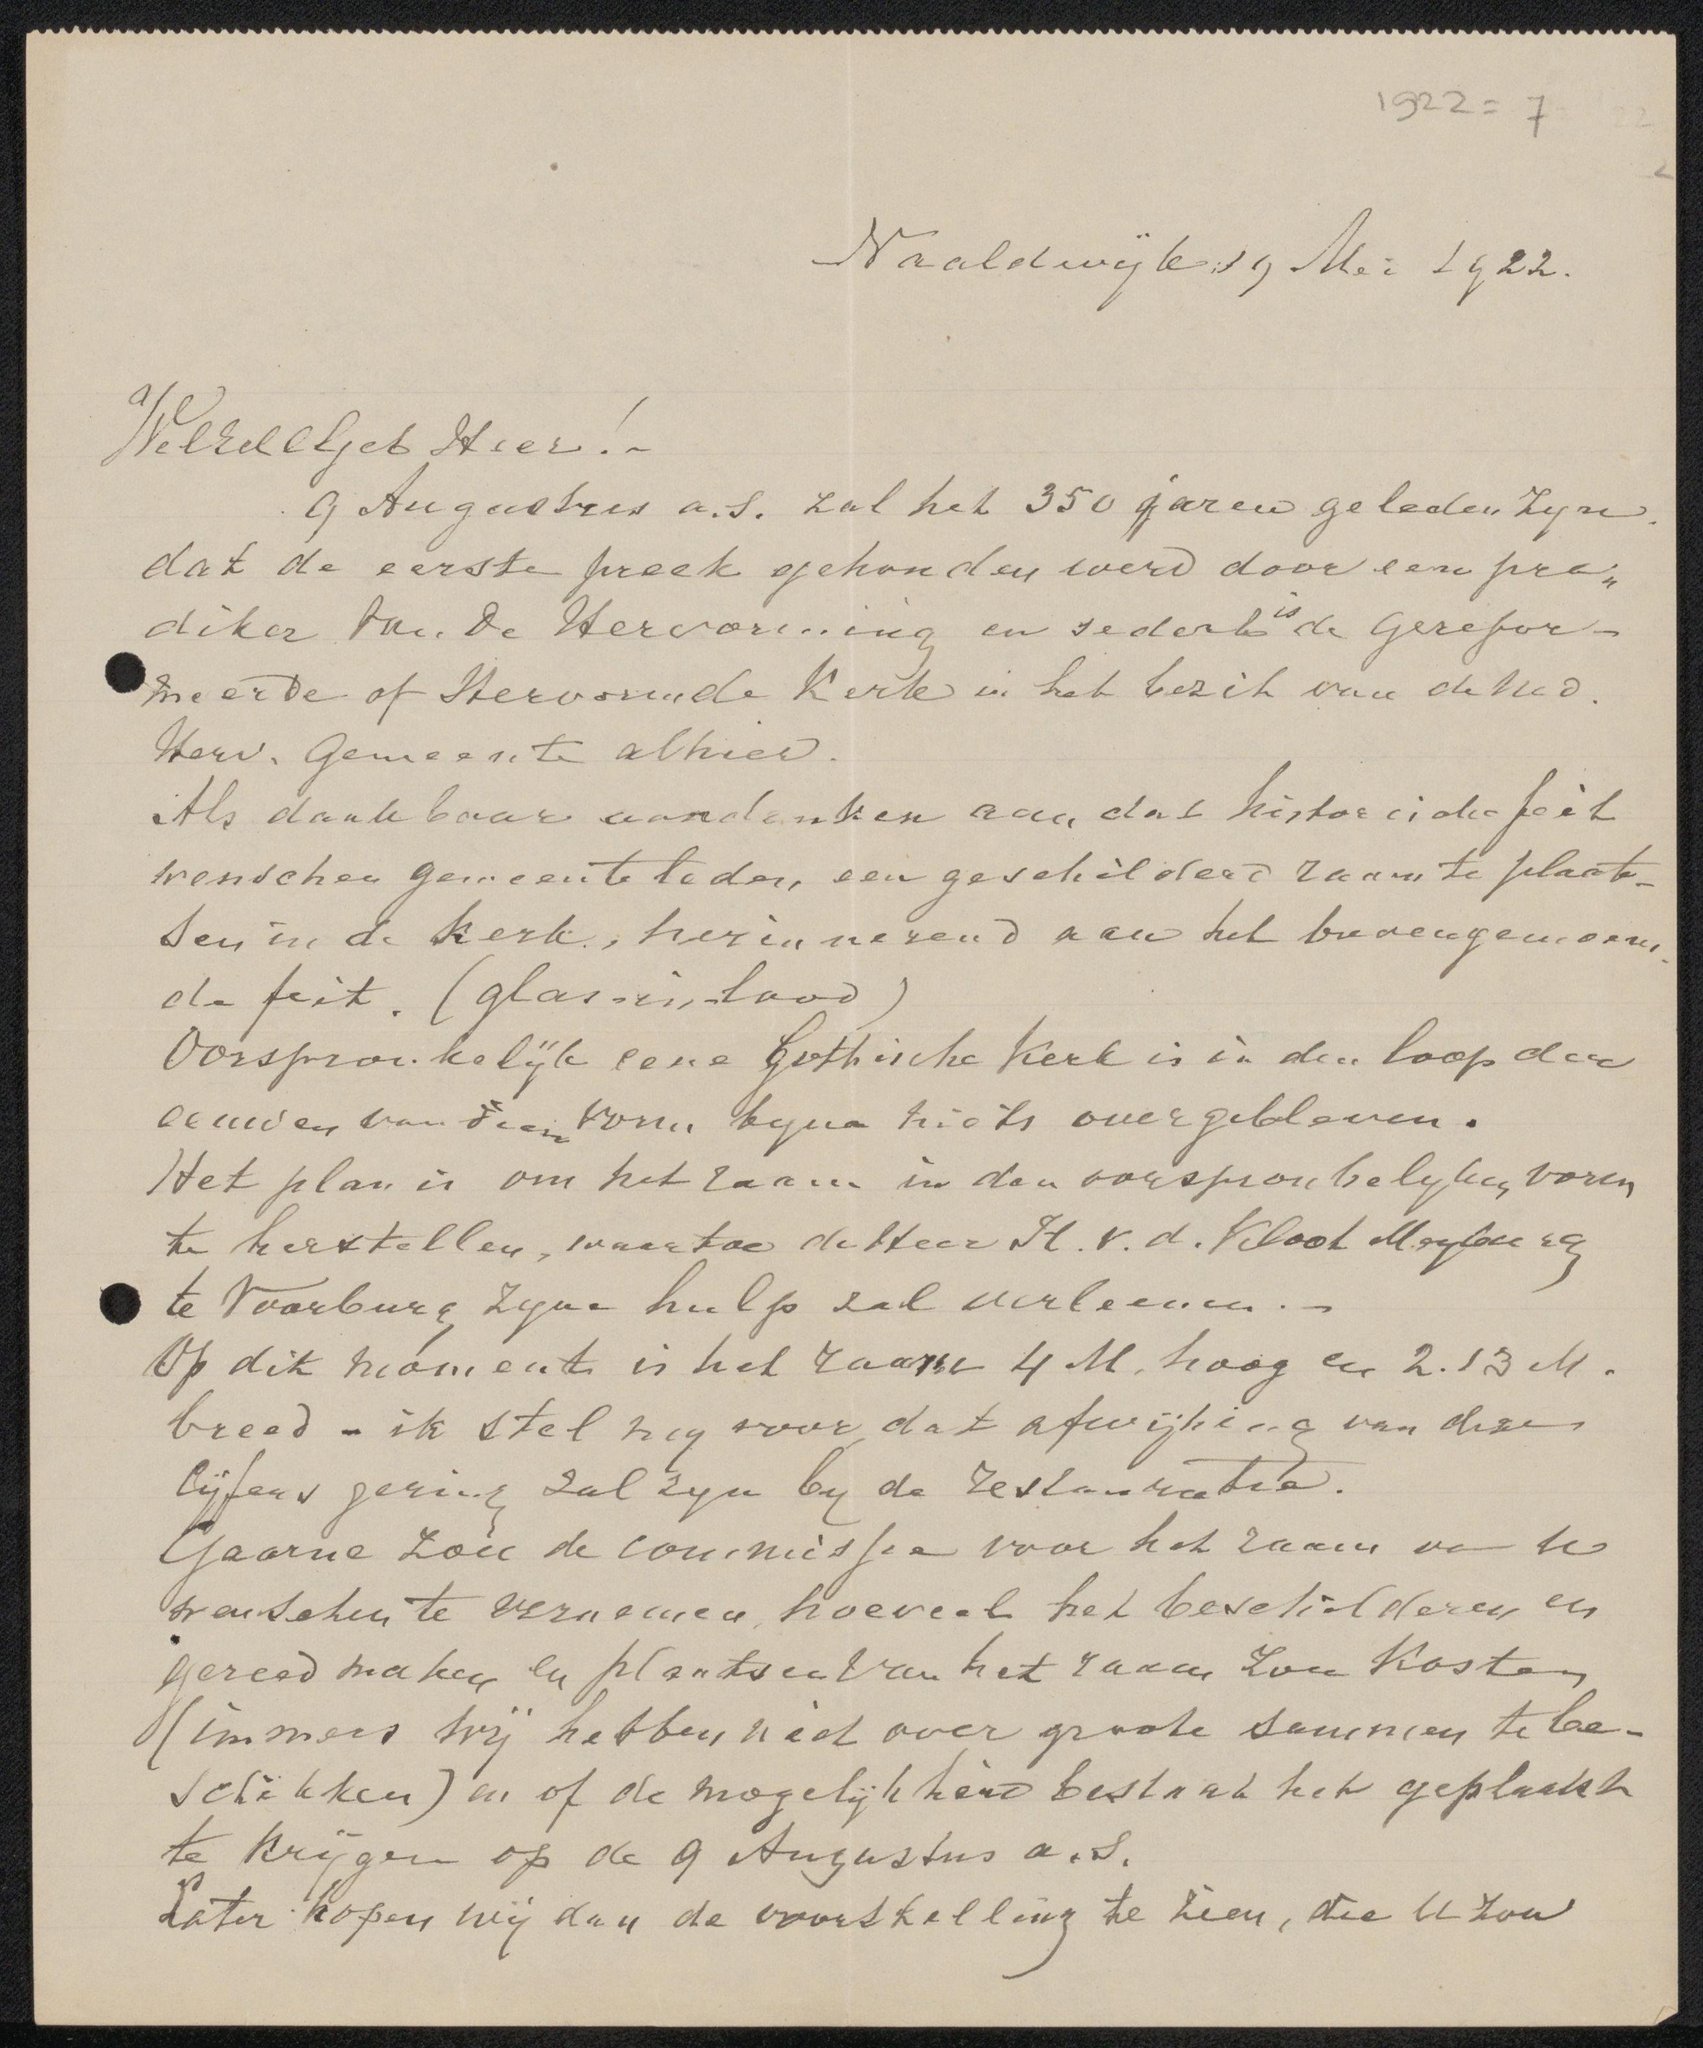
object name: letter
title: Brief aan Richard Roland Holst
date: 1922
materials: ink, paper, pencil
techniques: pen, writing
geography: naaldwijk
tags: richard nicolaüs roland holst, applied arts, arts and crafts; industrial design, money